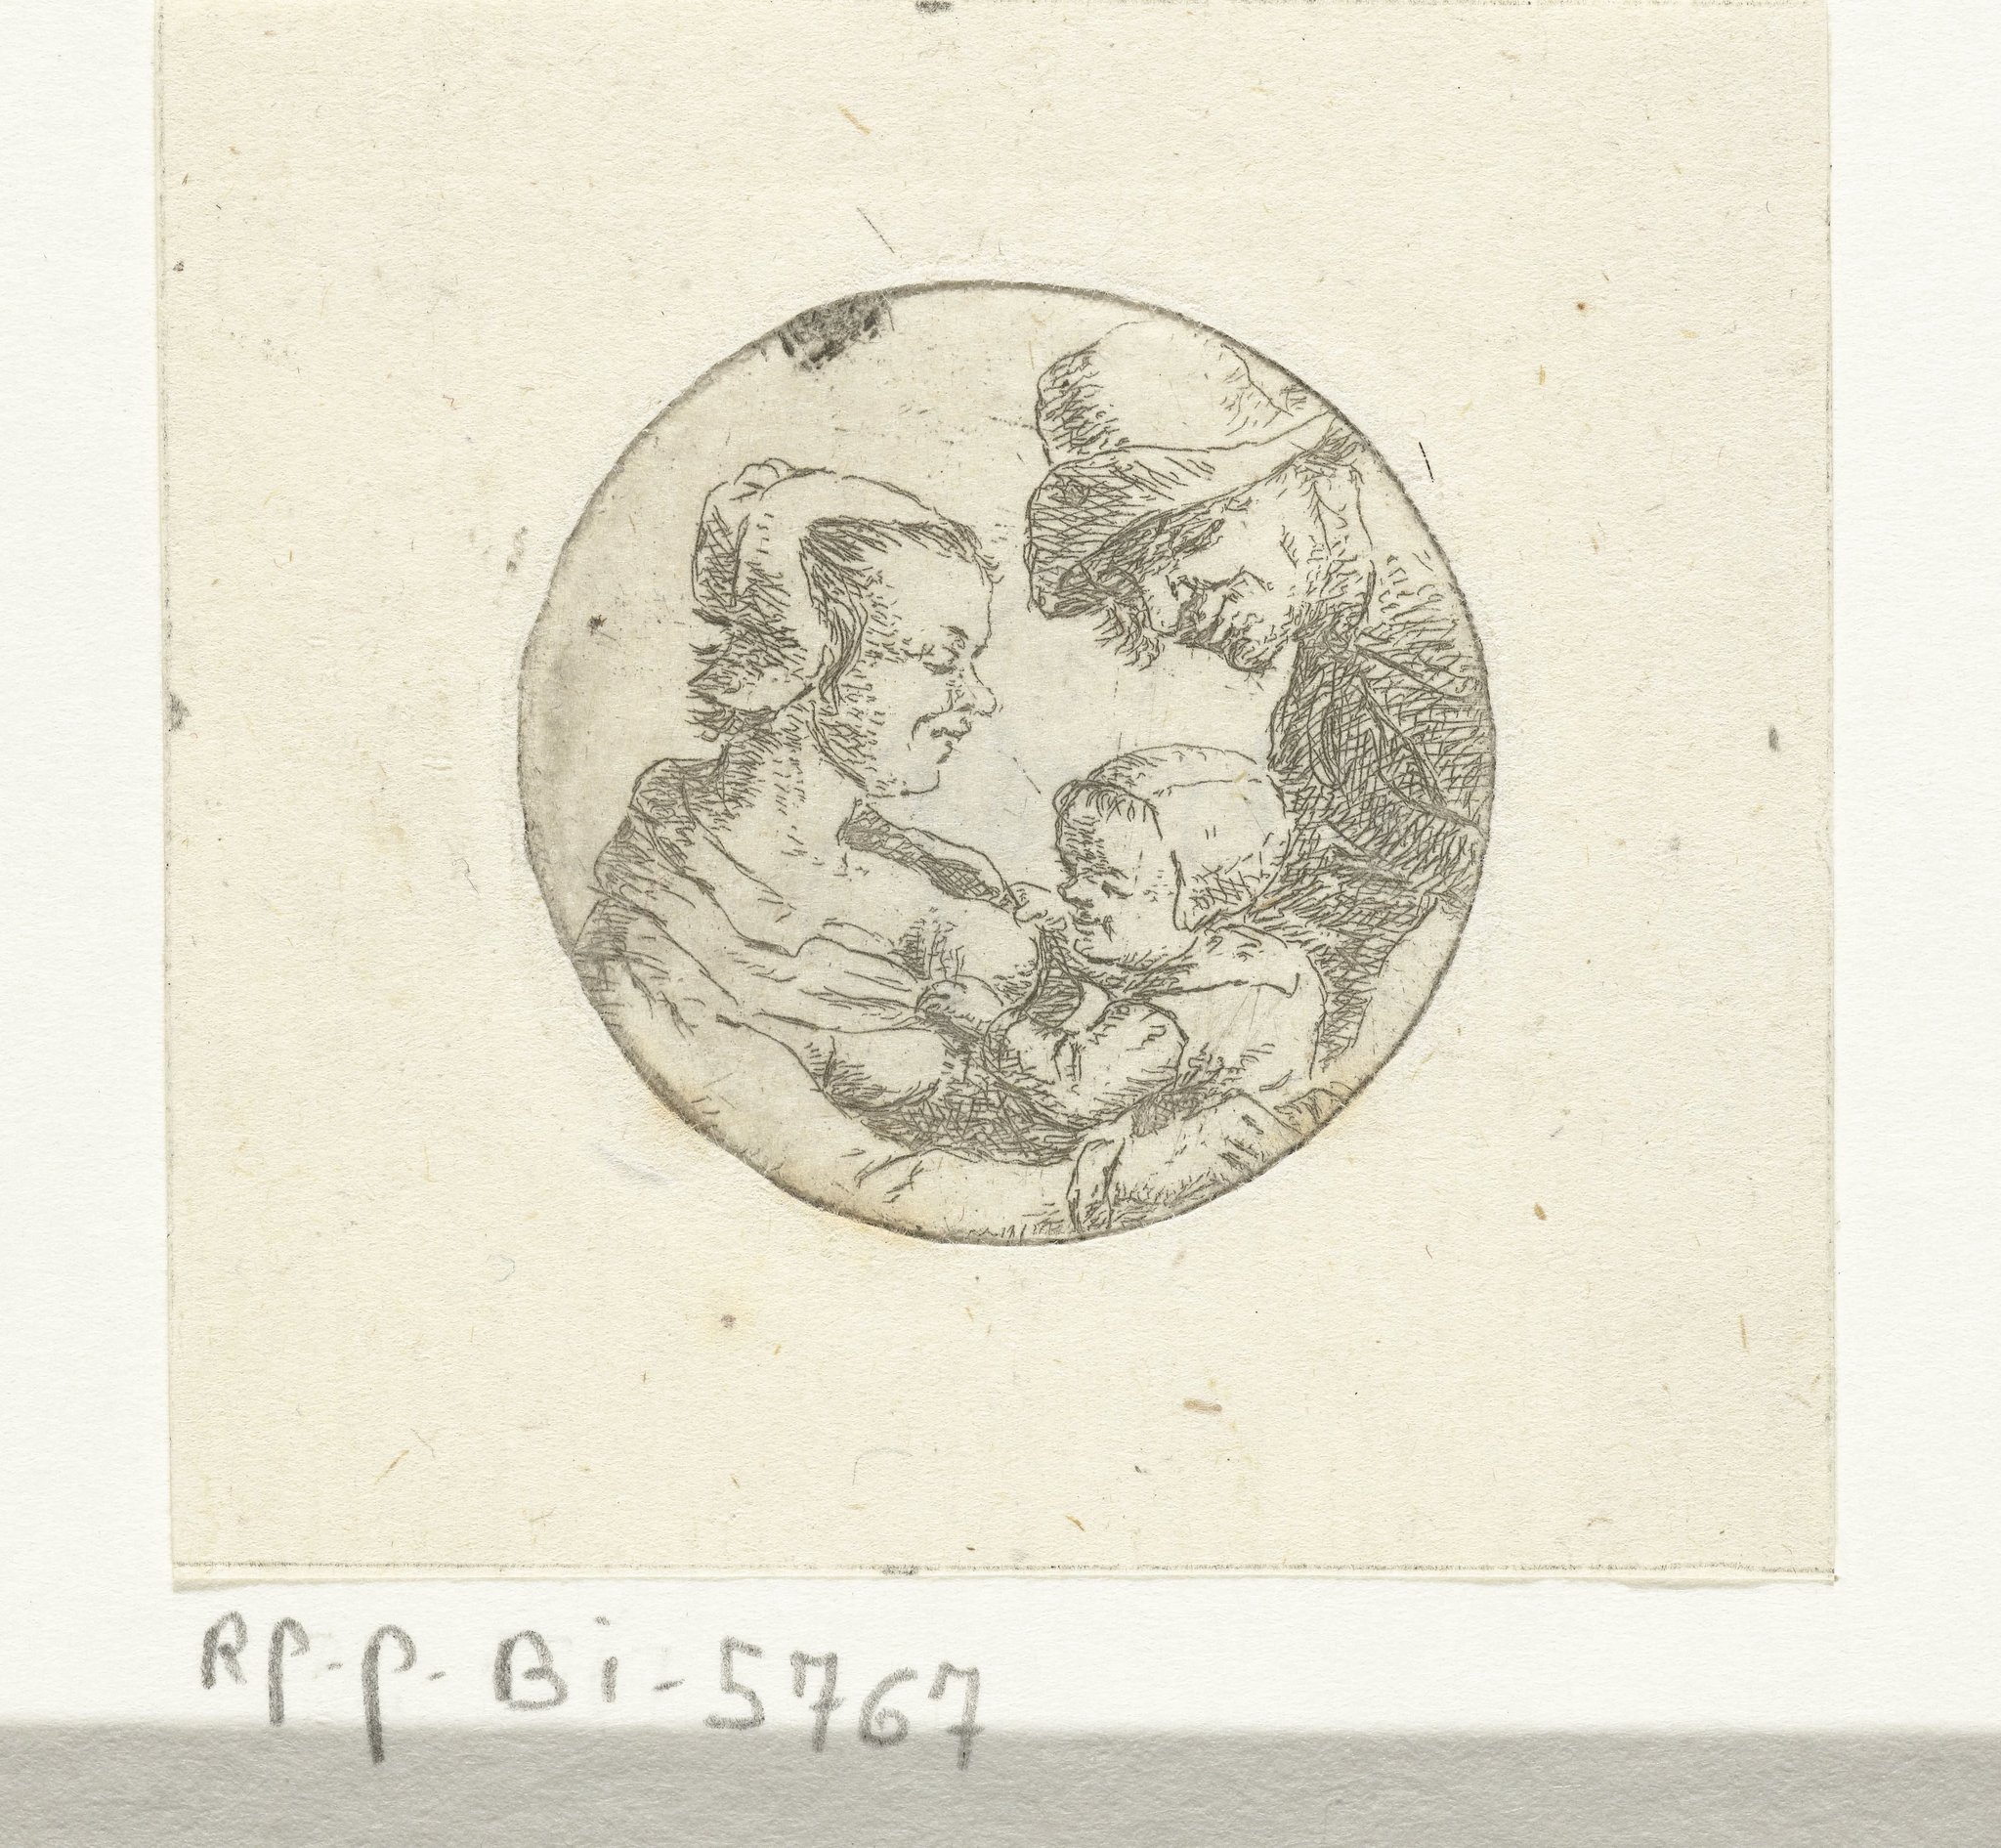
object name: print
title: Boer en boerin met kind (versie 1)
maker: christina chalon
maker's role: draughtsman, print maker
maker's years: 1748-1808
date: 1758-1808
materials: paper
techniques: etching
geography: leiden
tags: nursing, suckling, farmers, family group, especially parents with their child(ren) (with number of children)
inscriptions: collector's mark: Lugt 2228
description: Portret in ronde lijst van een onbekende boerenfamilie. Een vrouw geeft haar kind de borst terwijl haar man vertederd toekijkt.